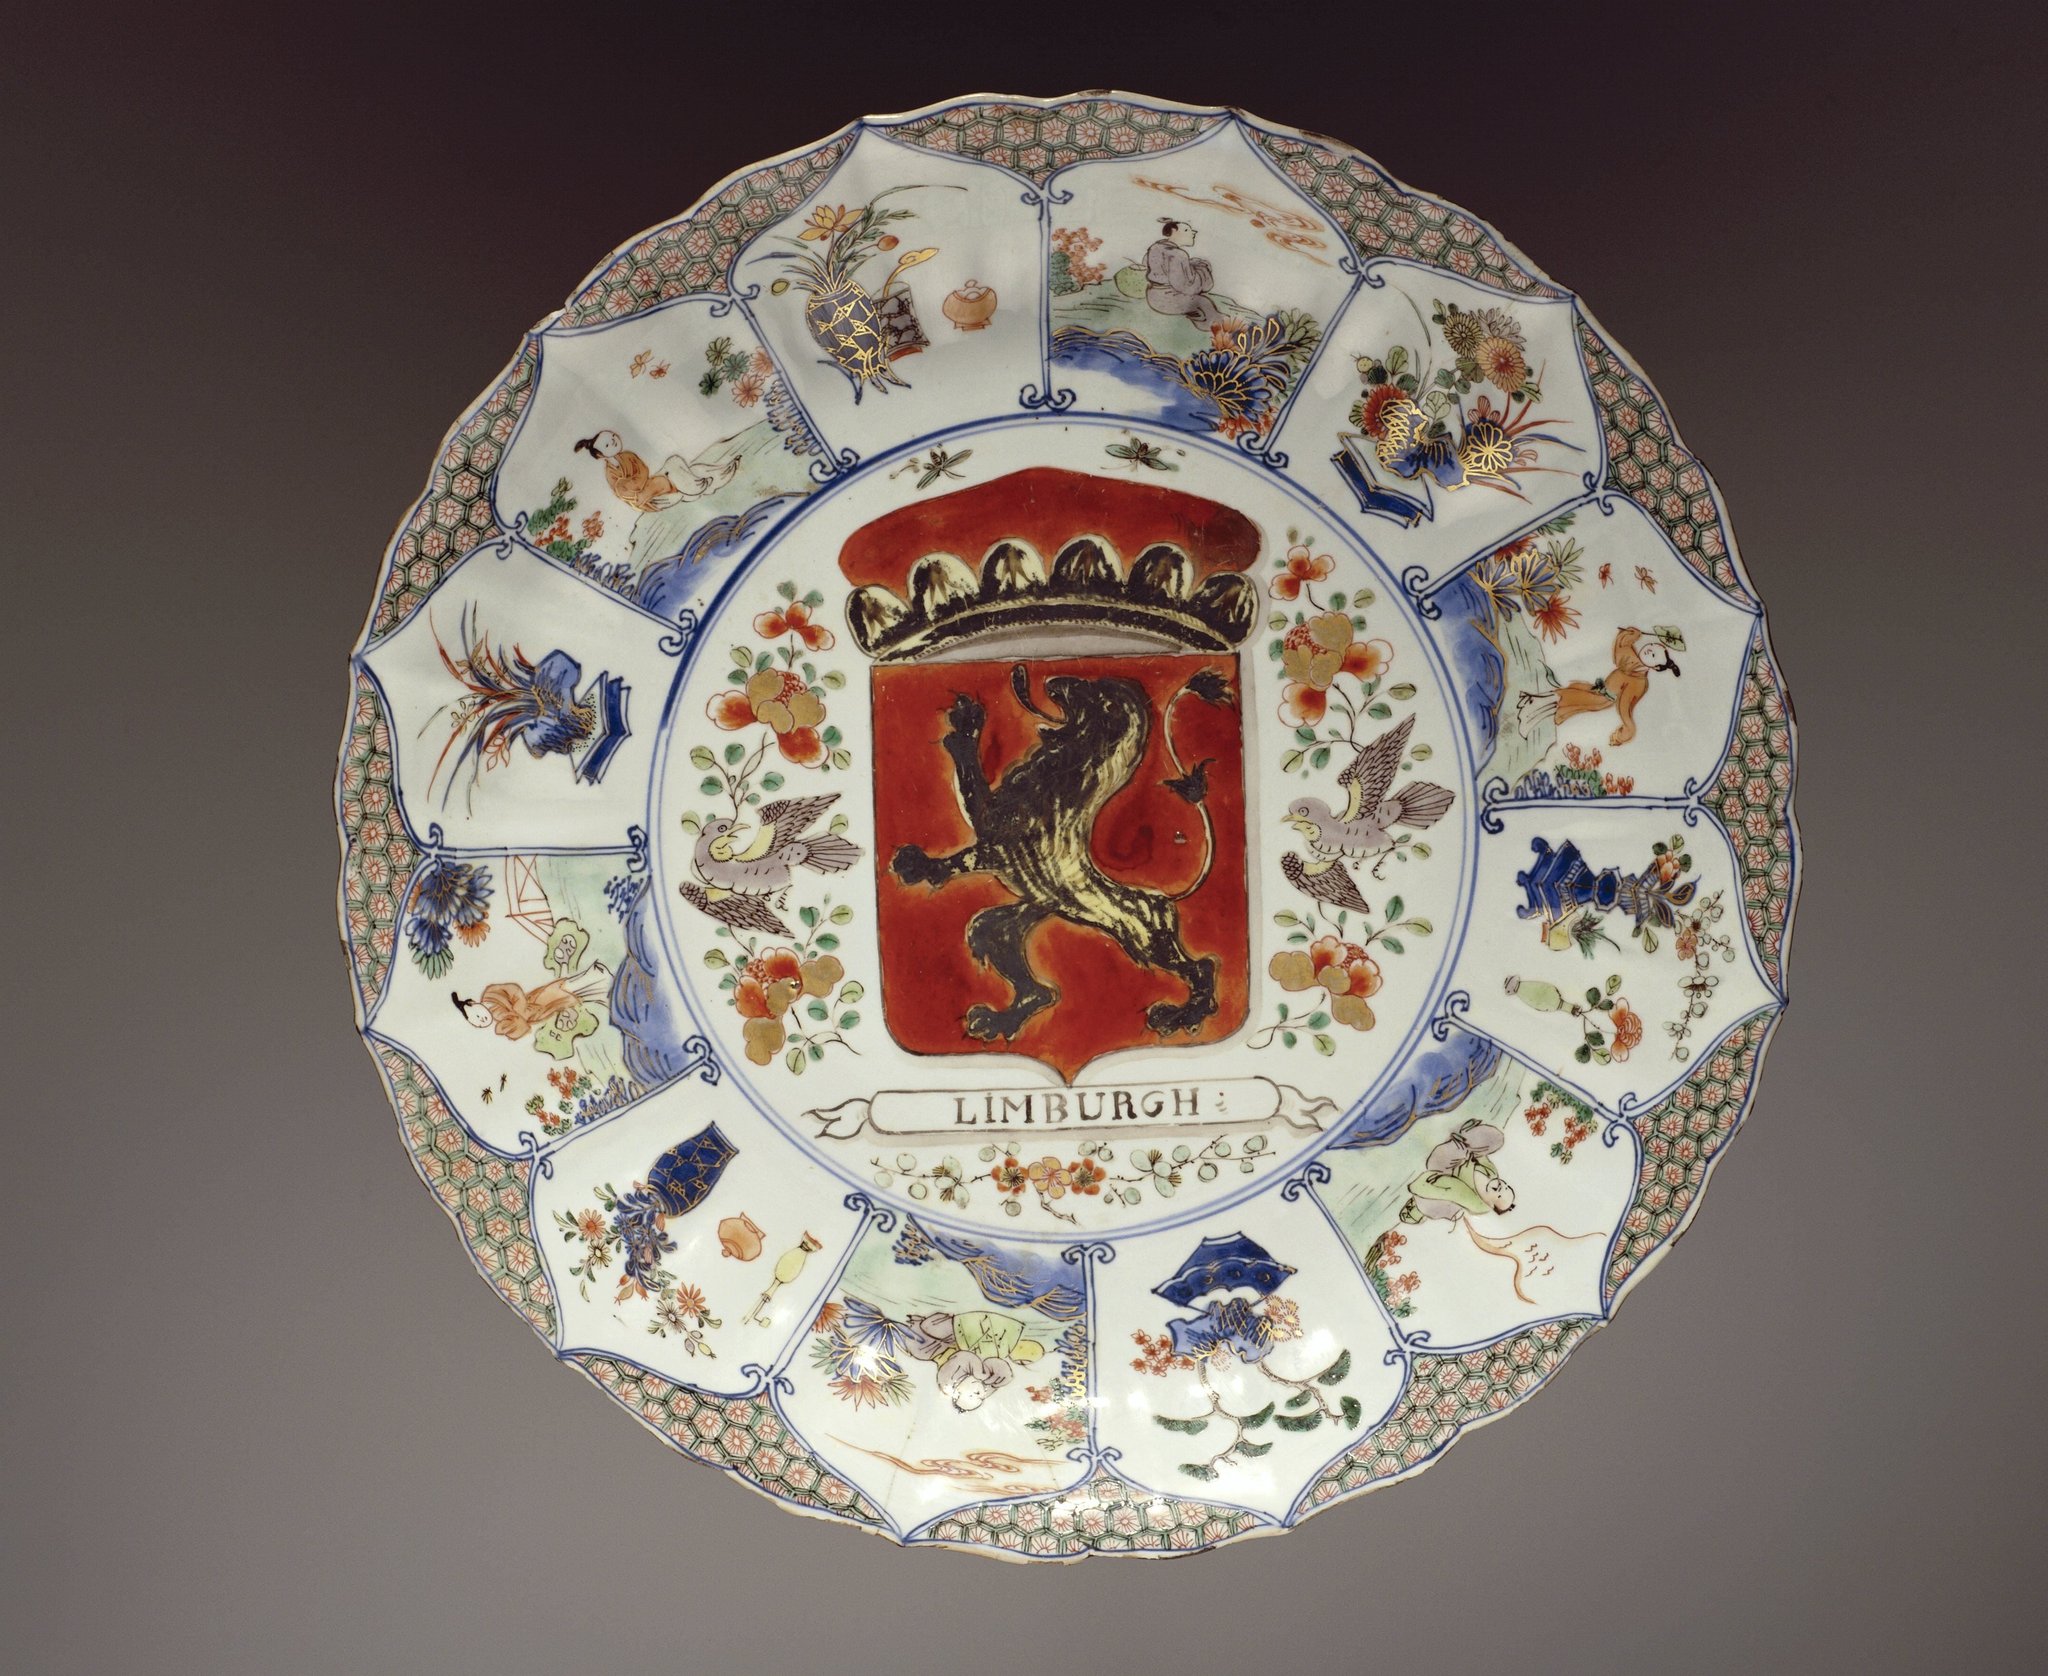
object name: platter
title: Dish with the arms of the province of Limburg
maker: Anonymous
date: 1700-1724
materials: glaze, gold, paint, porcelain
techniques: firing, gilding, turning, vitrification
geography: china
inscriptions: inscription: ‘LIMBURGH’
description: Schotel van porselein, 'Chine de Commande'. Beschilderd in 'famille verte' kleuren. In het plat het wapen van Limburg, met daaronder het woord Limburgh, omgeven door bloemtakken met vogels en vlinders.